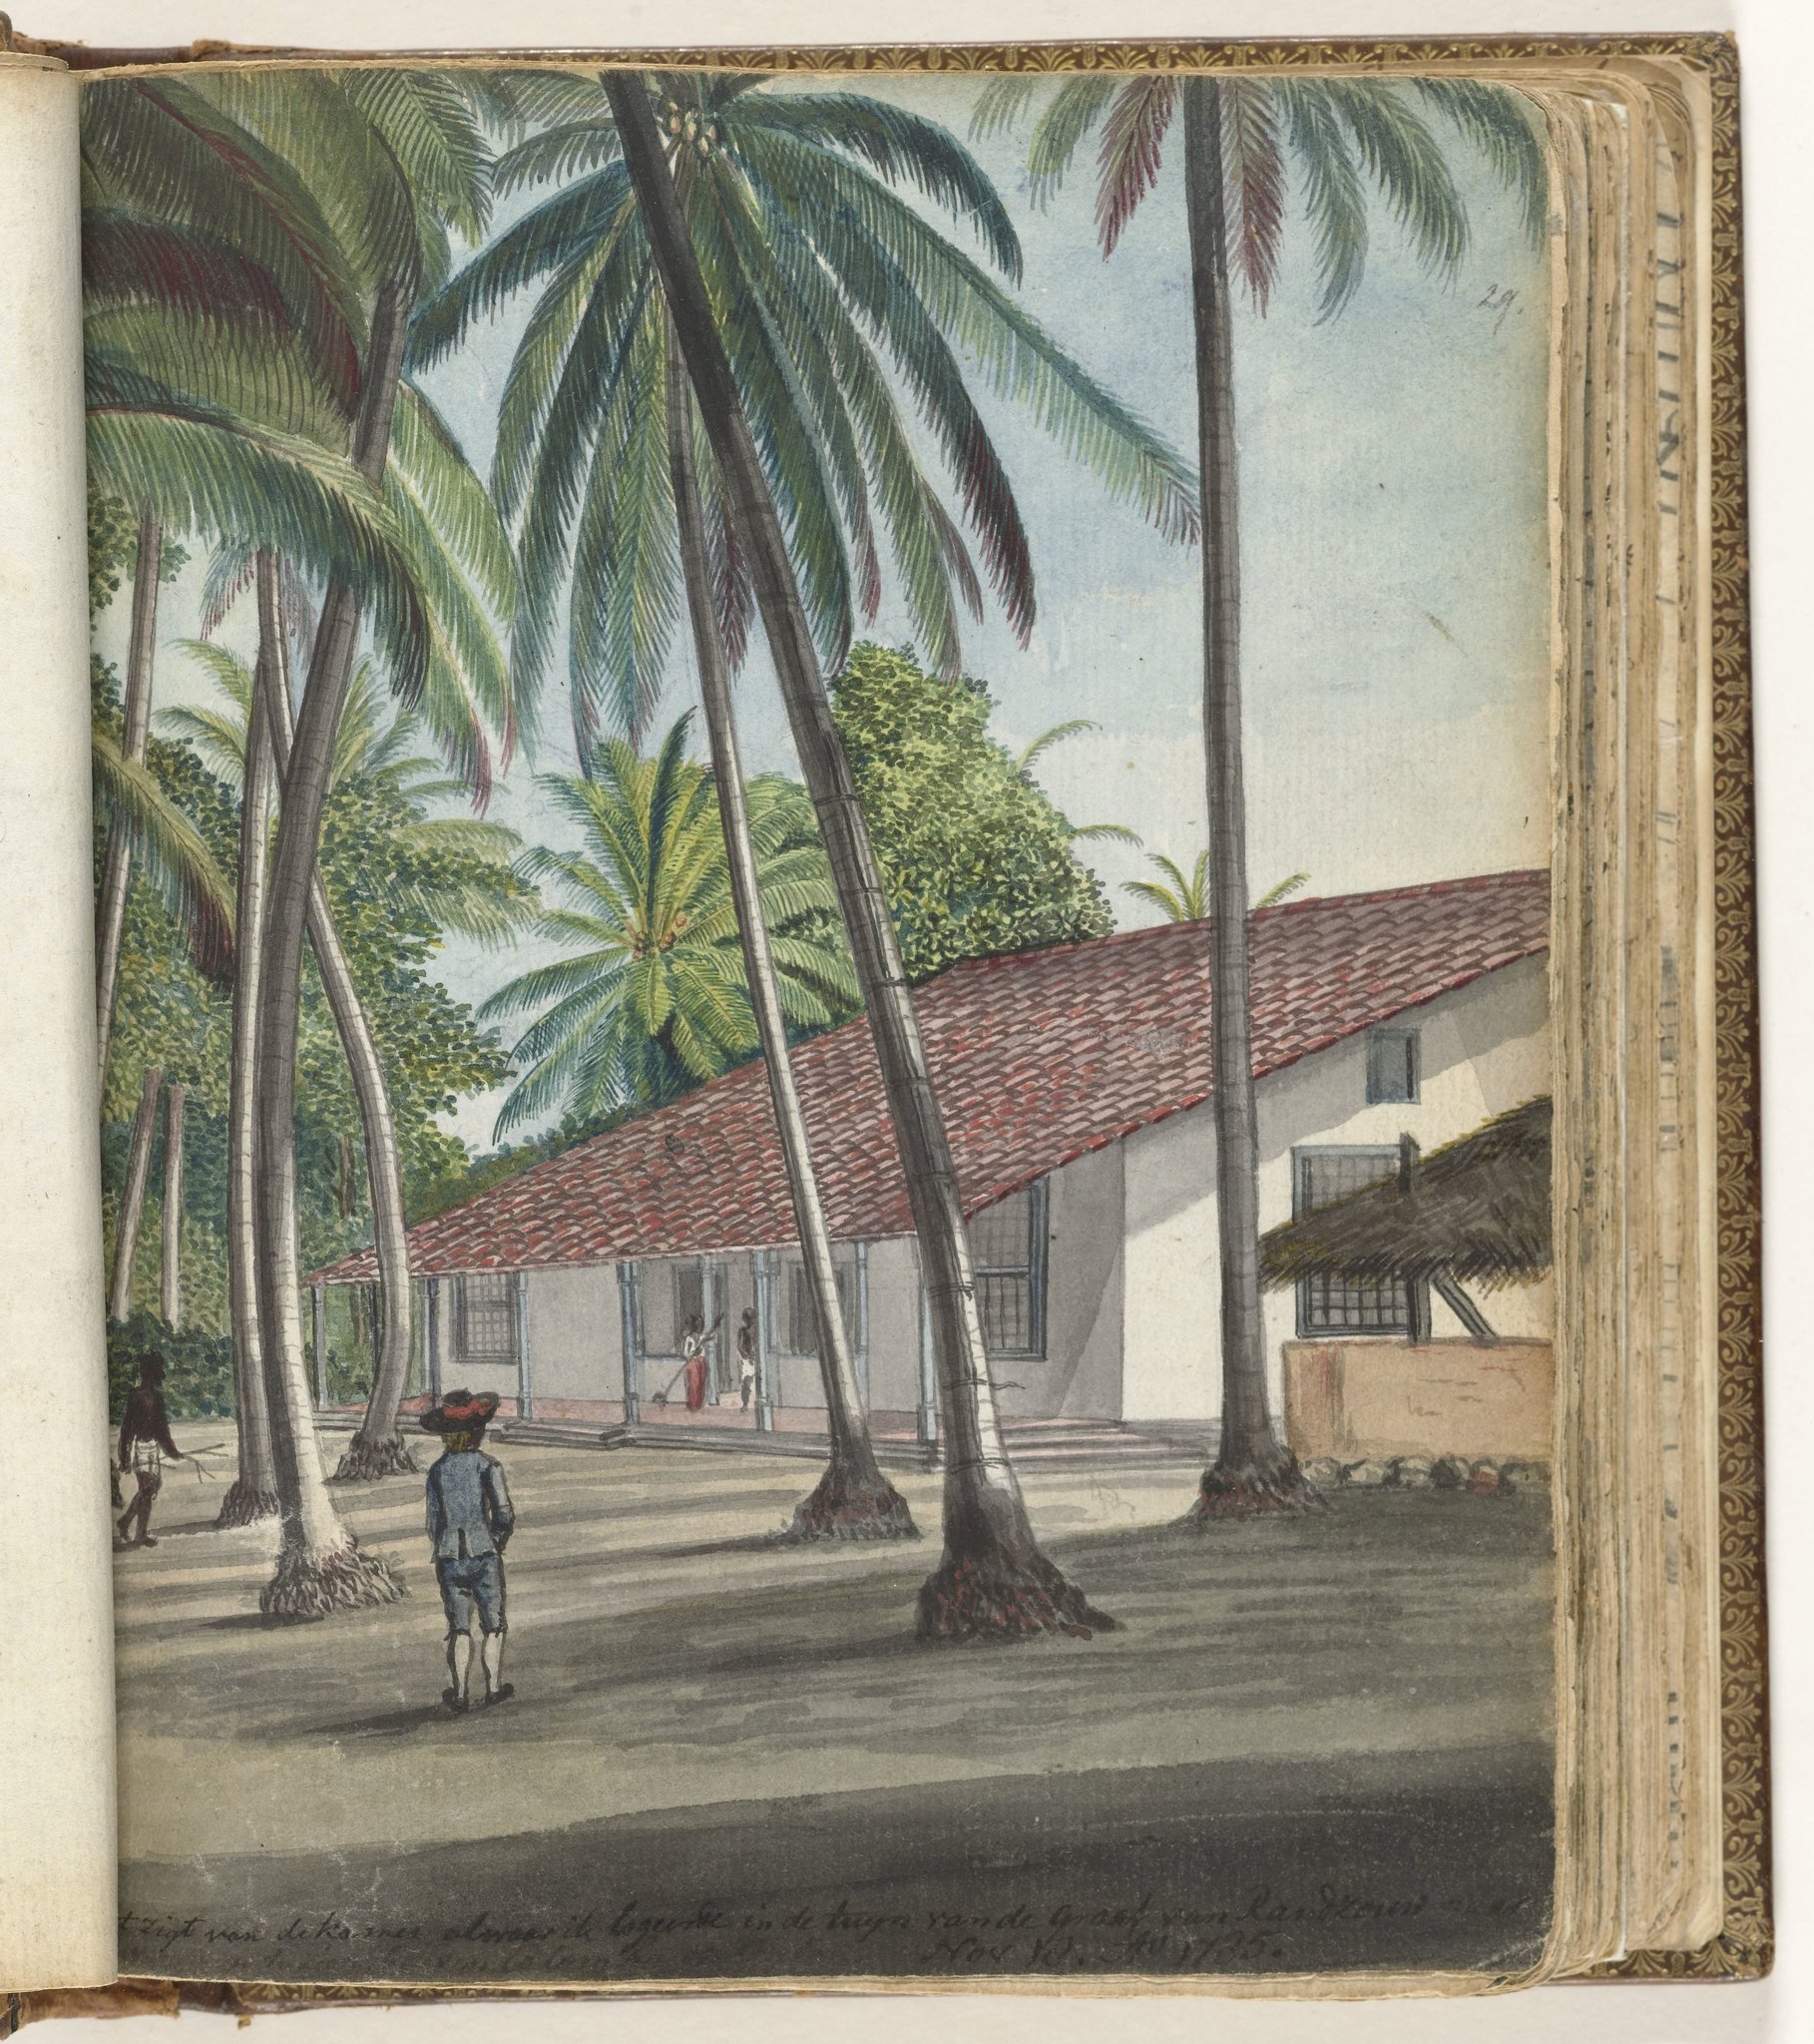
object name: drawing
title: Count Van Ranzow's Estate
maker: jan brandes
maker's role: draughtsman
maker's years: 1743-1808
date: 1785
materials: paper, pencil, watercolor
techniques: brush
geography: colombo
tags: batavia, slavery; serfs and enslaved persons, trees: palm-tree, sri lanka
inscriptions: inscription: ‘Uitzigt van de kamer alwaar ik logeerde in de tuyn van de graaf van Randzouw naar.. Nov. 18 Ao 1785’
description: Kleurtekening van een erf met klapperbomen en een wit gebouw met rood pannedak, in blauw pak vermoedelijk Jantje, de zoon van de tekenaar. Op de achtergrond slaaf gemaakte mensen. Met opschrift. Onderdeel uit het schetsboek van Jan Brandes, dl. 2 (1808), p. 29.